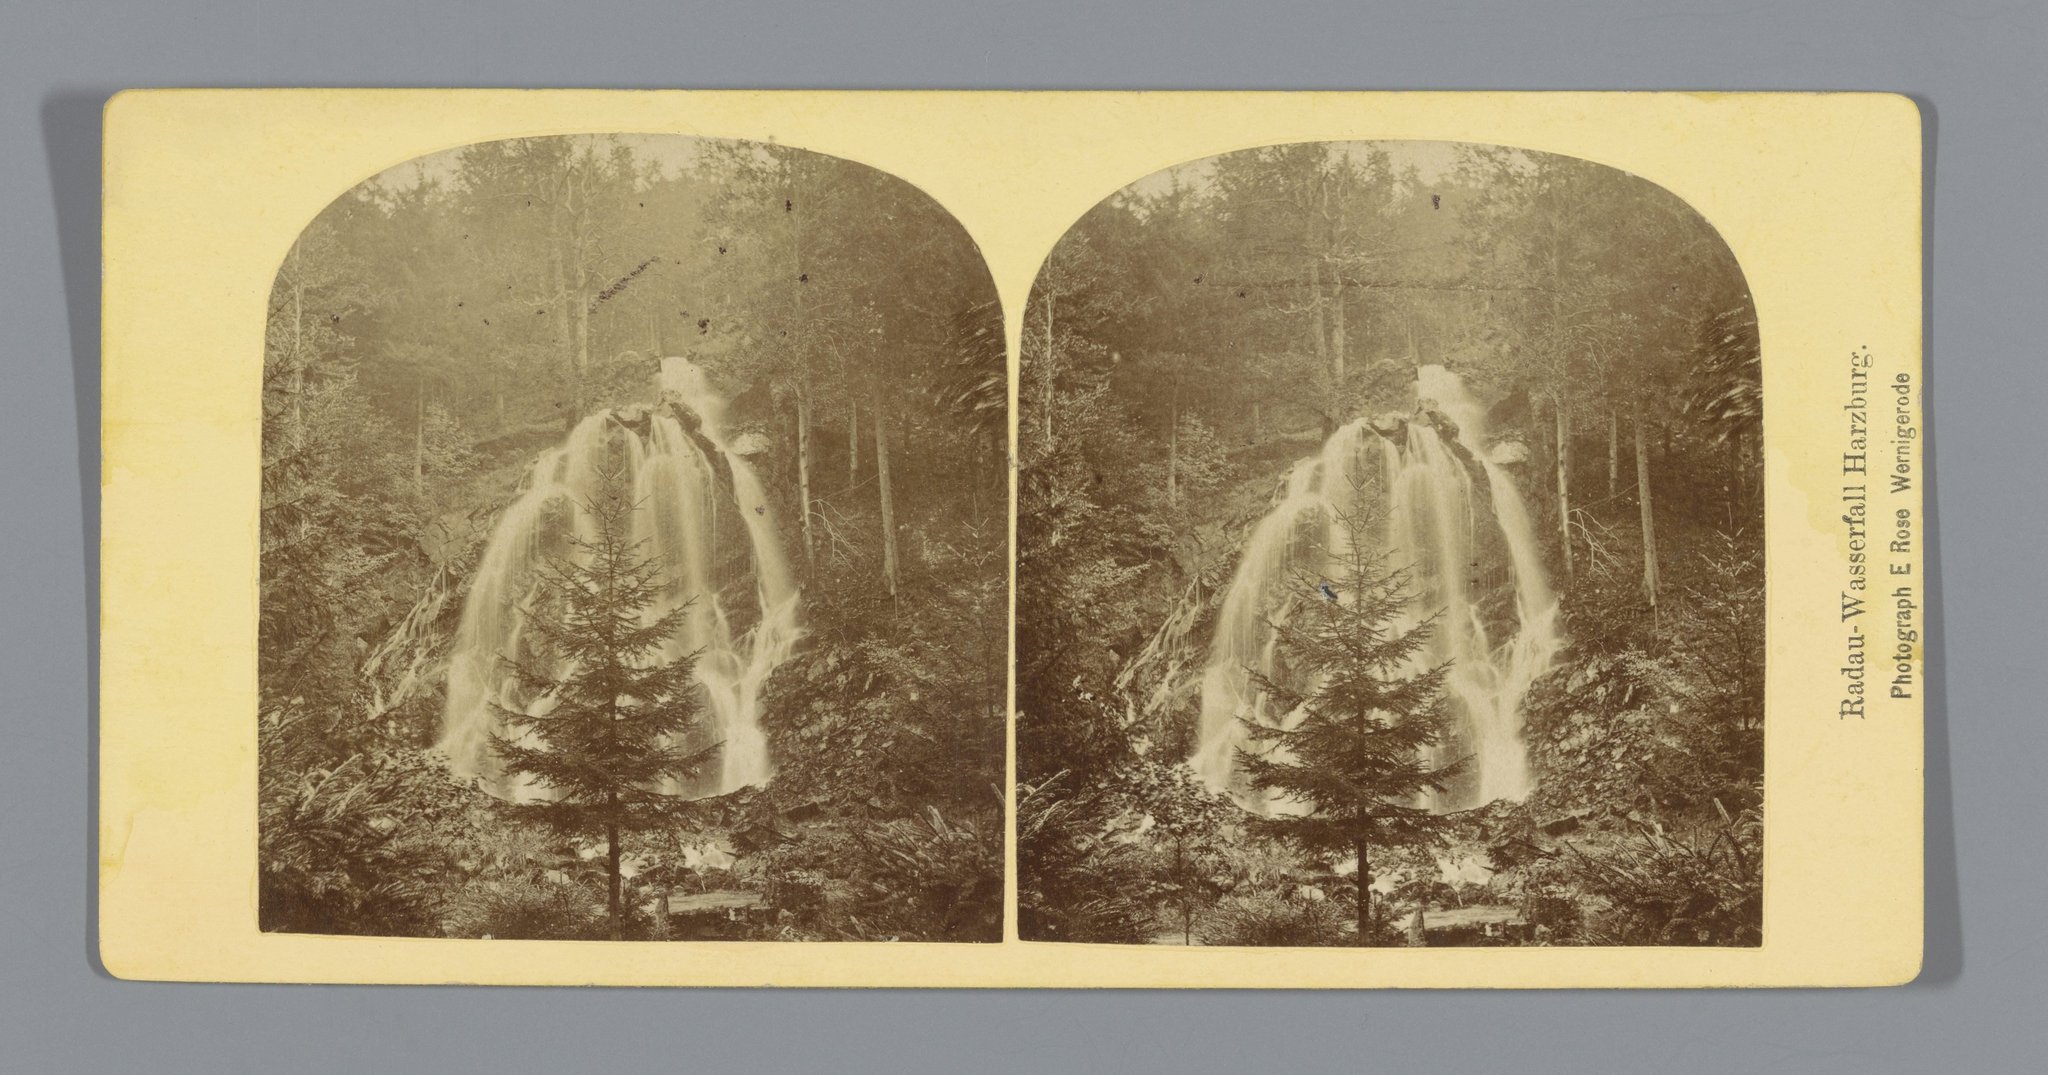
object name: stereograph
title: Radau-Wasserfall Harzburg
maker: e. rose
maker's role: fotograaf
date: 1855-1880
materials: cardboard, photographic support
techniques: albumen print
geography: harz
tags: waterfall